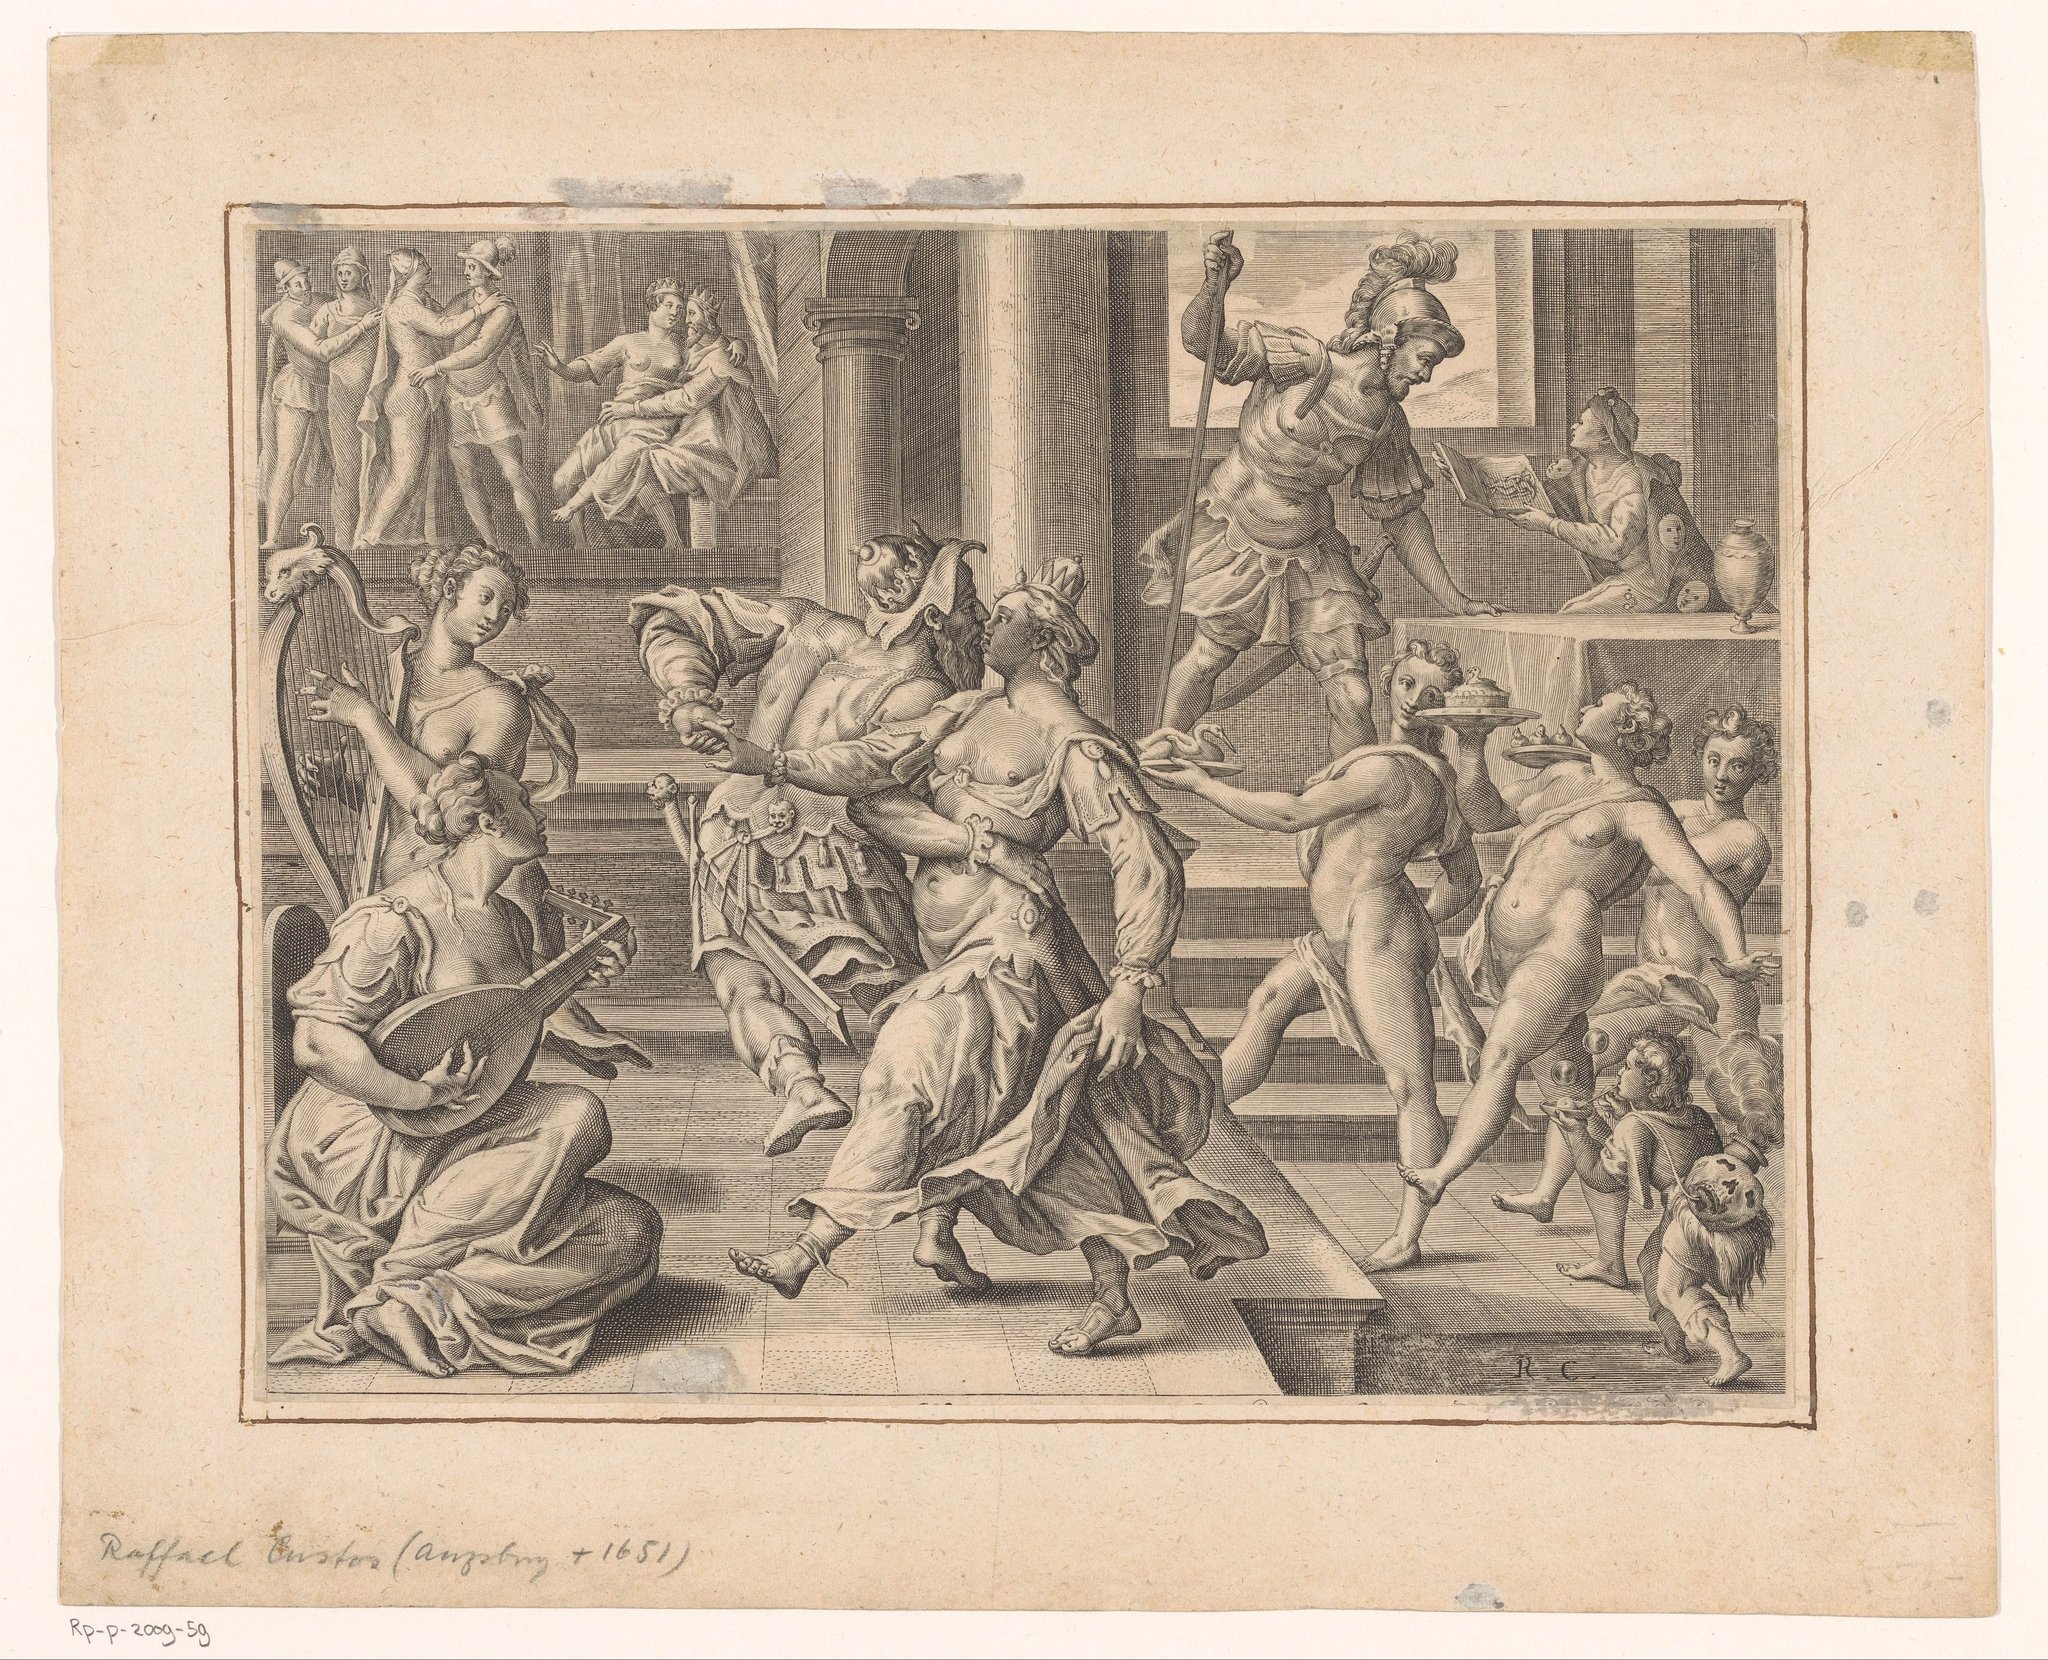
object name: print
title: Feestend gezelschap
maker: raphael custos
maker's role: print maker, publisher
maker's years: 1590-1664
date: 1600-1664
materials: paper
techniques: engraving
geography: germany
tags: private festivities, merry company (+ dancing ~ festive activities), harp, lute, and special forms of lute, e.g.: theorbo, cheat, deceit; 'fraude', 'inganno' (ripa) (+ personification)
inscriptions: collector's mark: Lugt 3836, collector's mark: Lugt 2228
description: Dansend paar begeleid door vrouwen op luit en harp. Rechts brengen drie figuren voedsel binnen. In dezelfde hoek staat een bellenblazend kind. In de achtergrond staan drie vrijende paren en toont de personificatie van bedrog een erotische afbeelding aan een krijgsman.